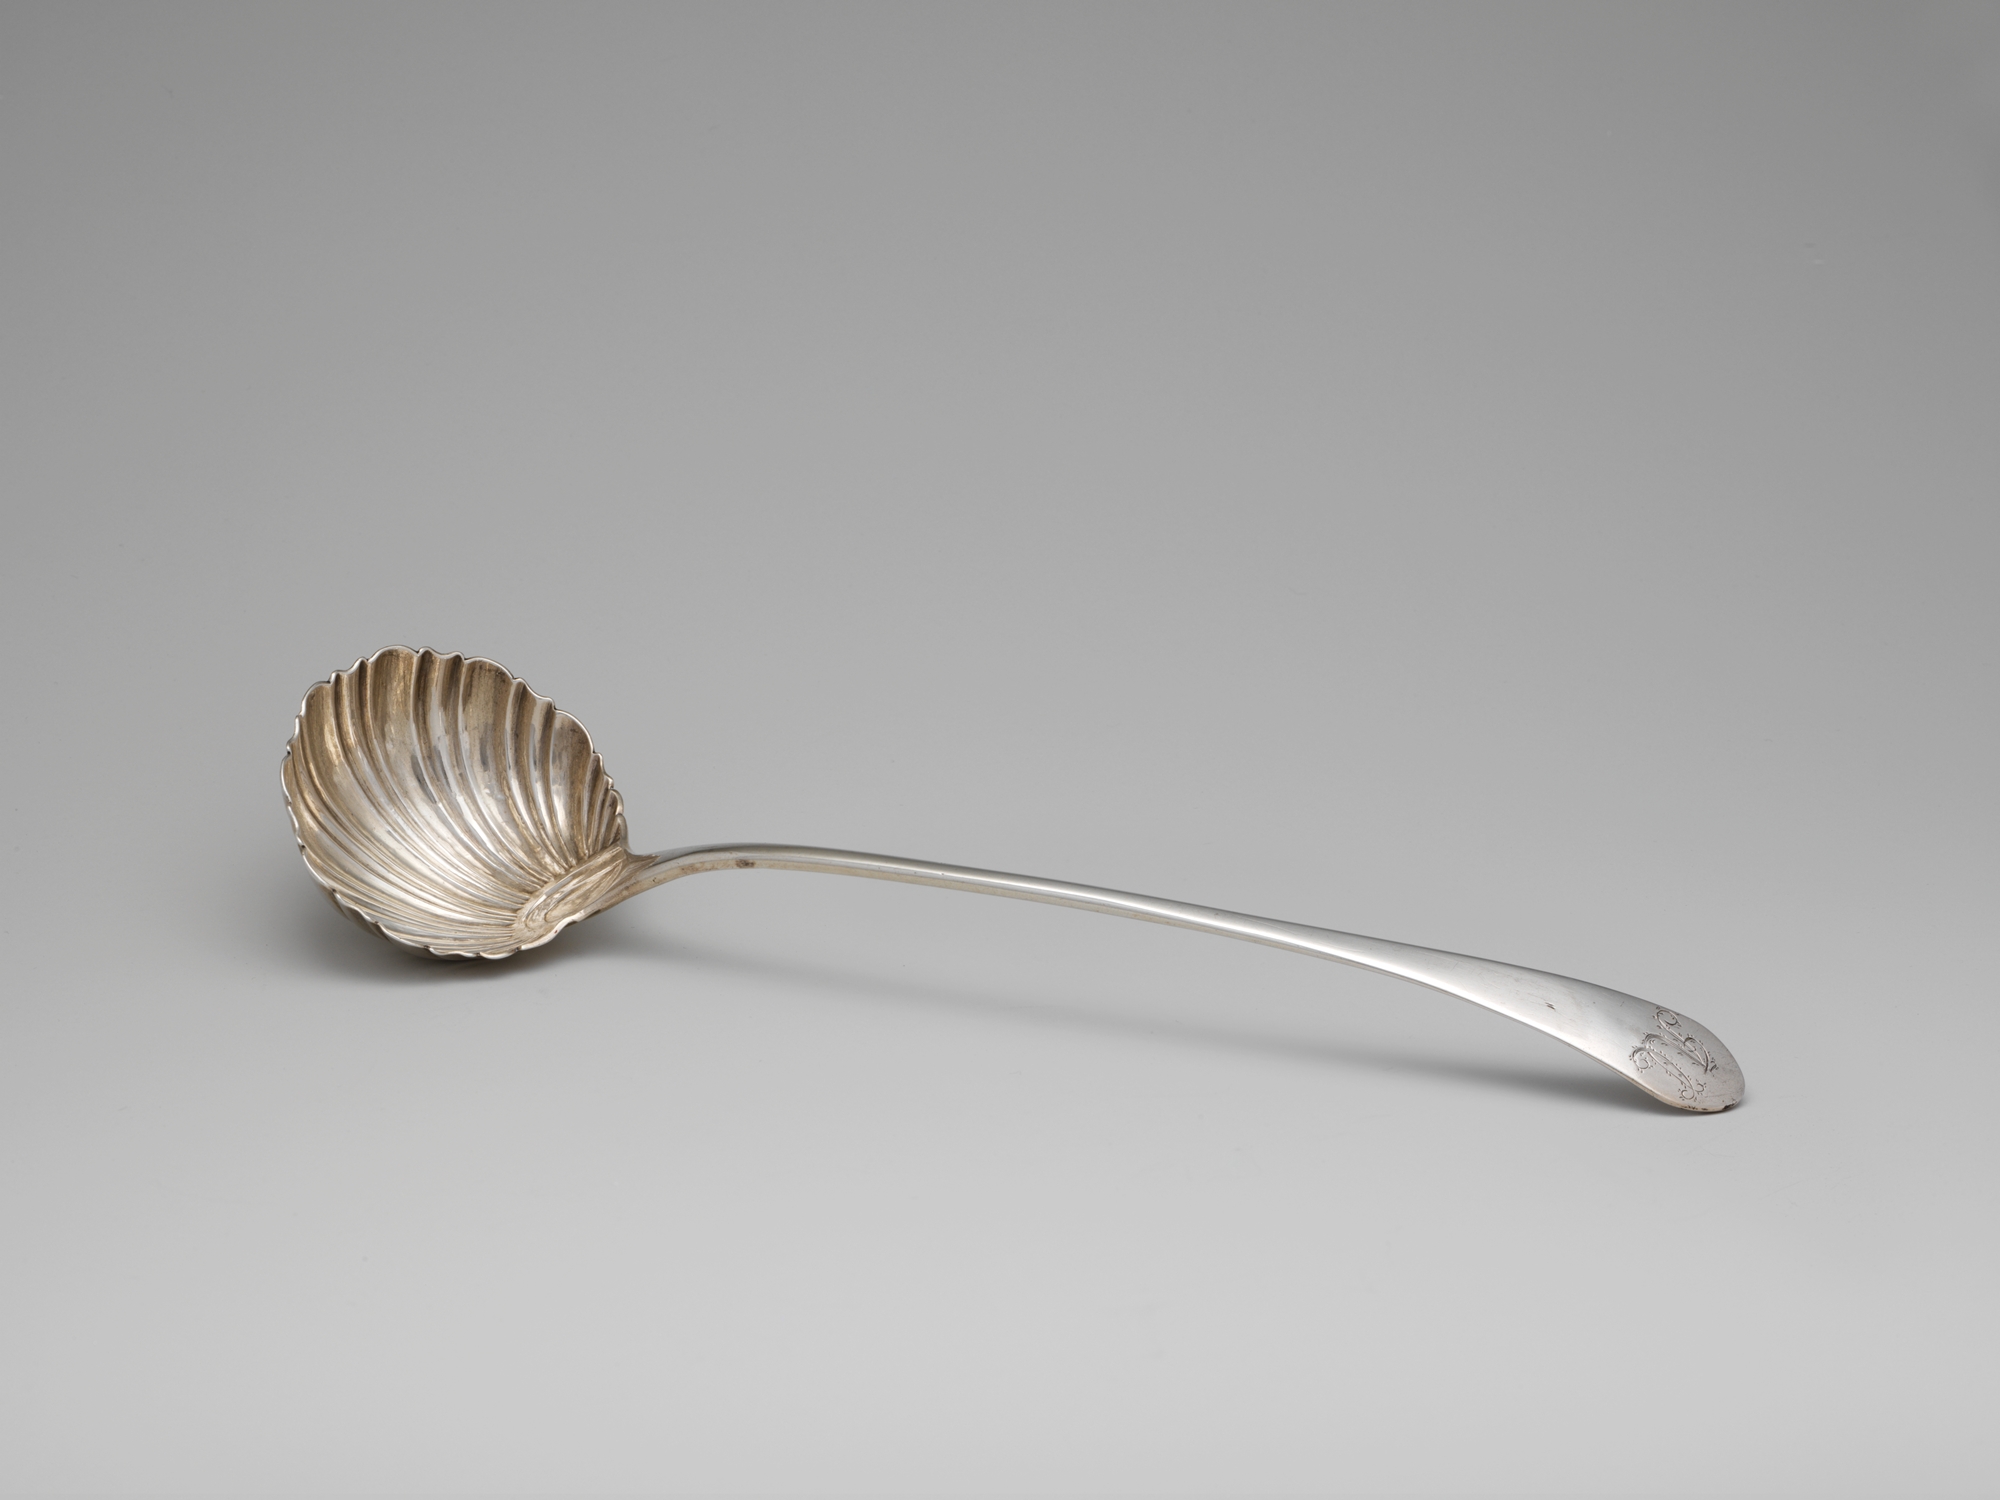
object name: ladle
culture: american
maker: samuel tingley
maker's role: maker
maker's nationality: american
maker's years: 1759-1796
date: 1775-1796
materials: silver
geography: united states